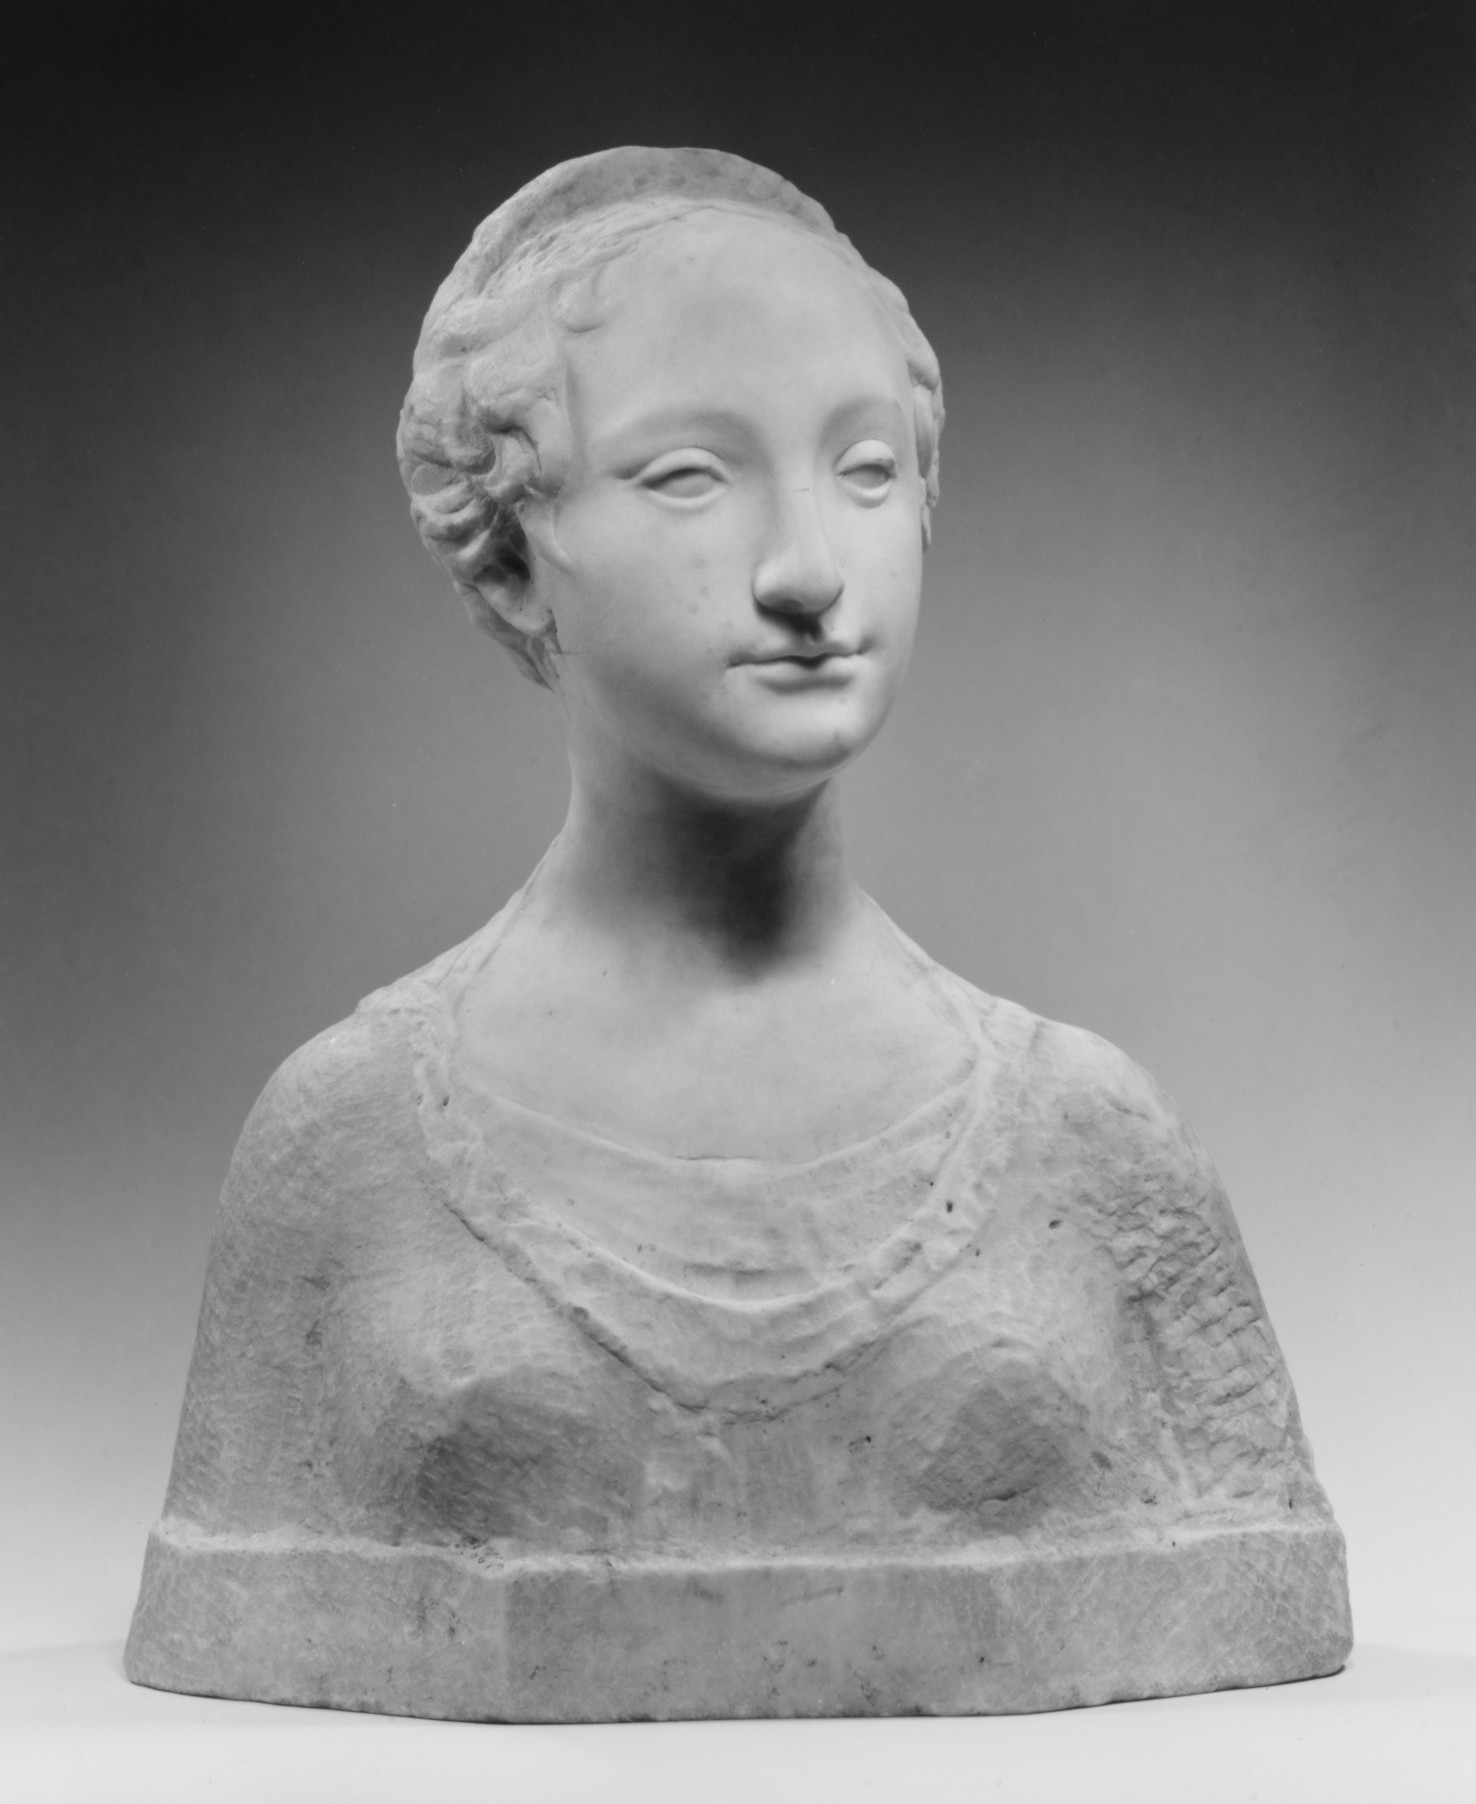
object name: bust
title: Young woman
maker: mino da fiesole (mino di giovanni)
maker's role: artist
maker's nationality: italian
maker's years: 1429-1484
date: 1875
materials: marble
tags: portraits,women